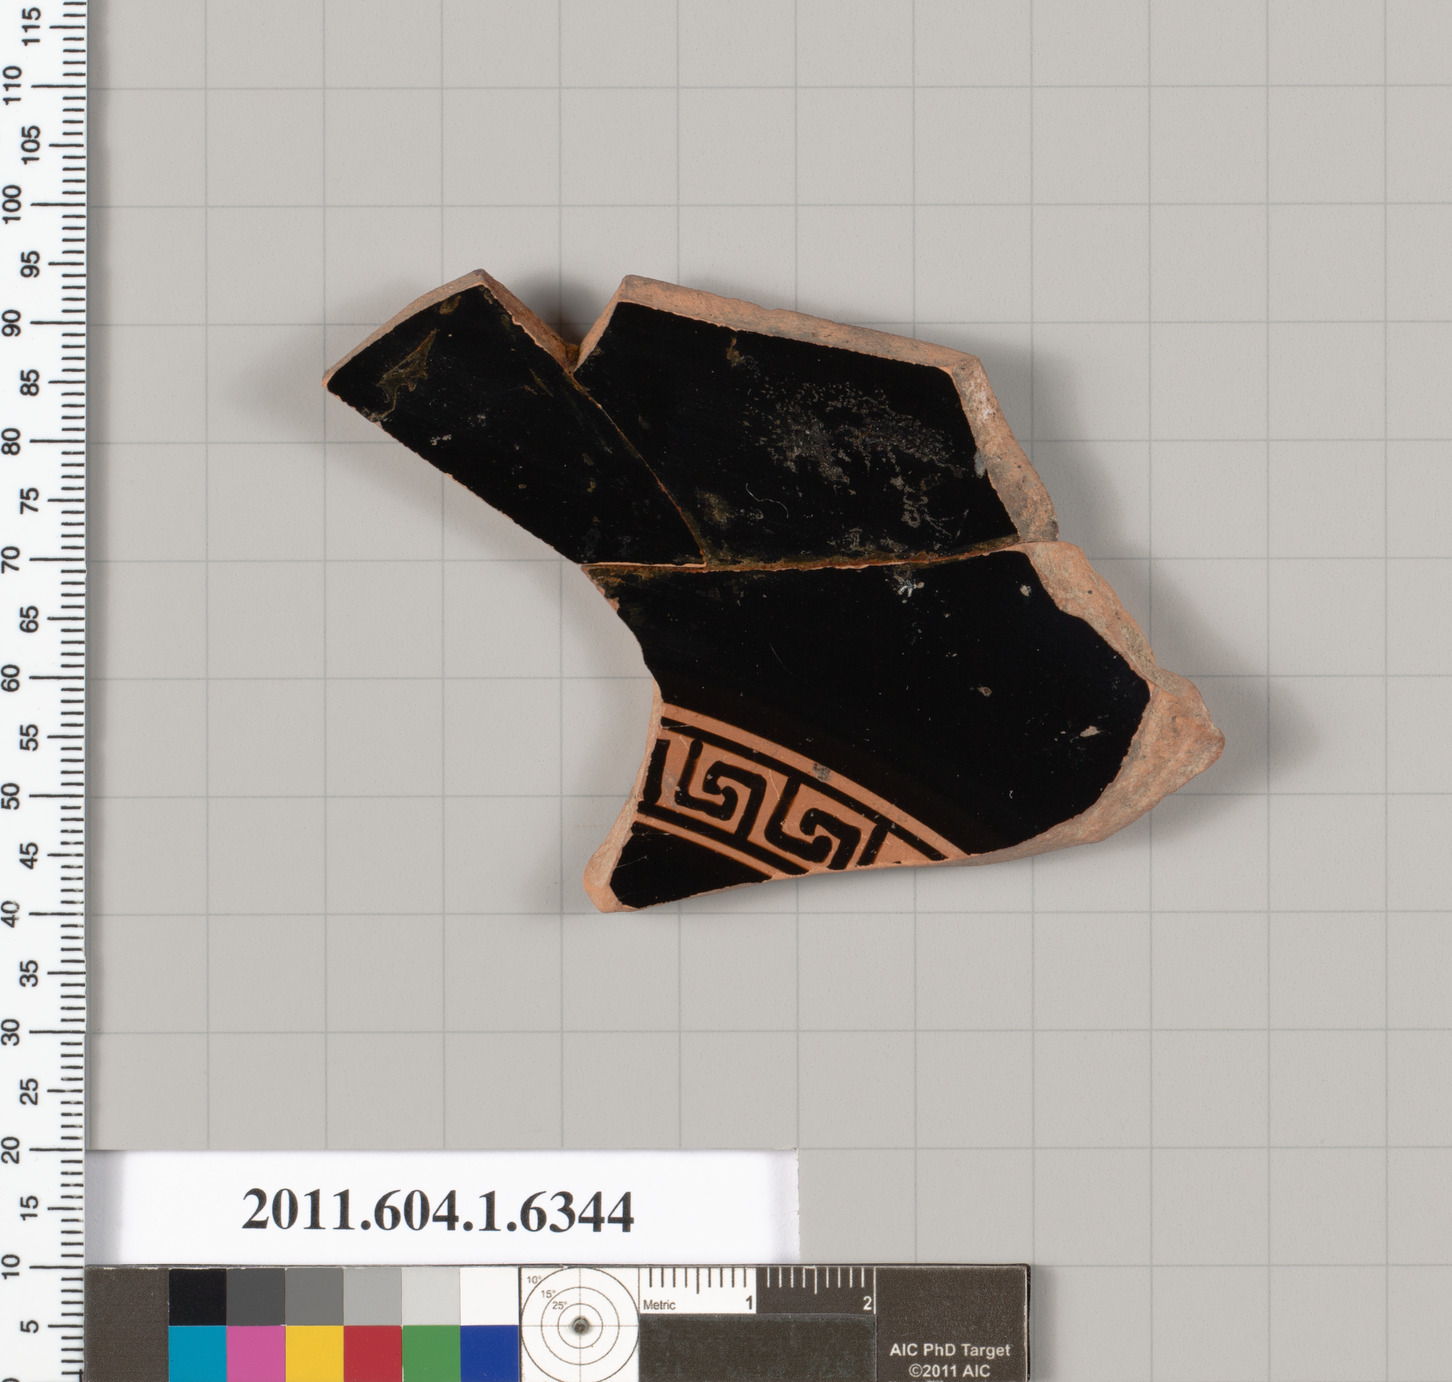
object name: kylix fragment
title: Terracotta fragment of a kylix (drinking cup)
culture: greek, attic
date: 500-480 BCE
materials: terracotta